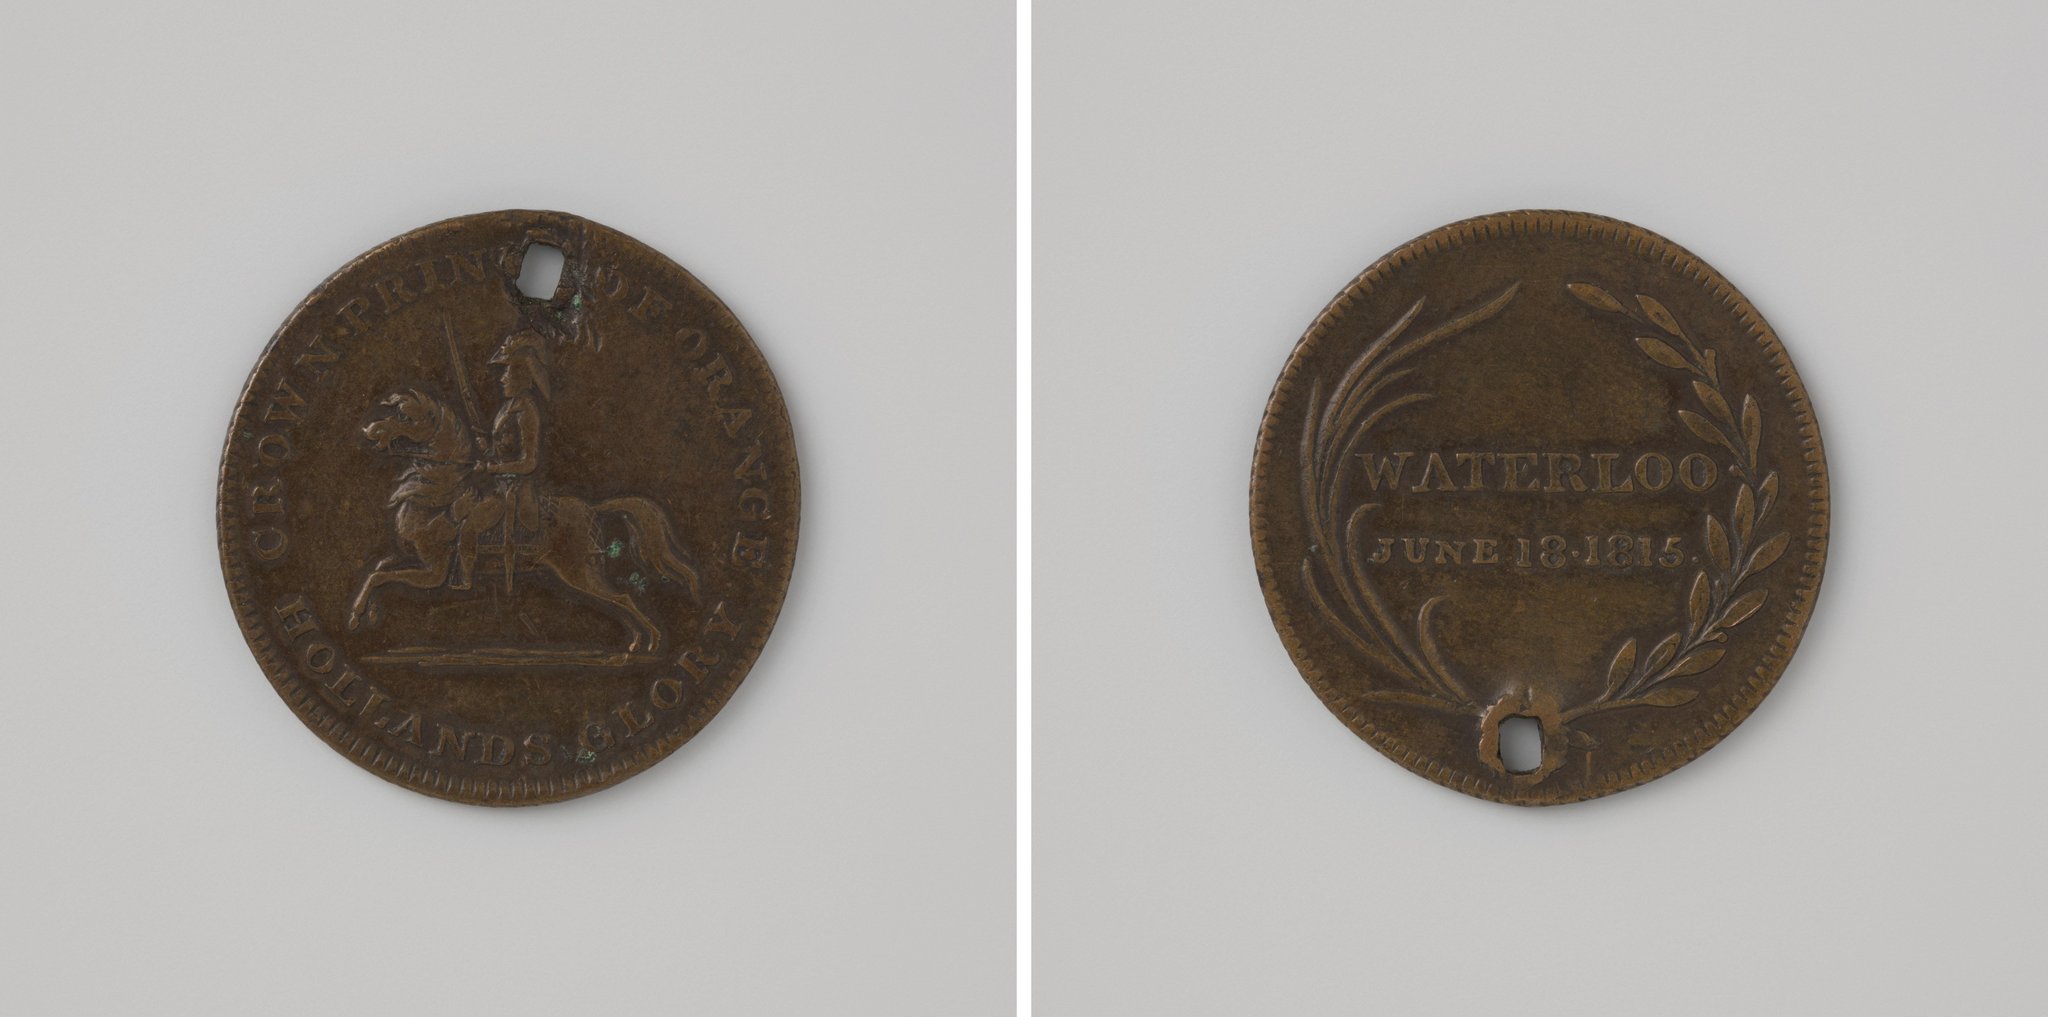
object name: history medal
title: De Prins van Oranje in de Slag bij Waterloo 1815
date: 1815-1865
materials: brass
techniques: striking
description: Messing penning met doorboring, op de voorzijde de kroonprins met blanke sabel te paard naar links, met omschrift, op de keerzijde twee regels tekst tussen palm- en lauwertak, Engelstalig.